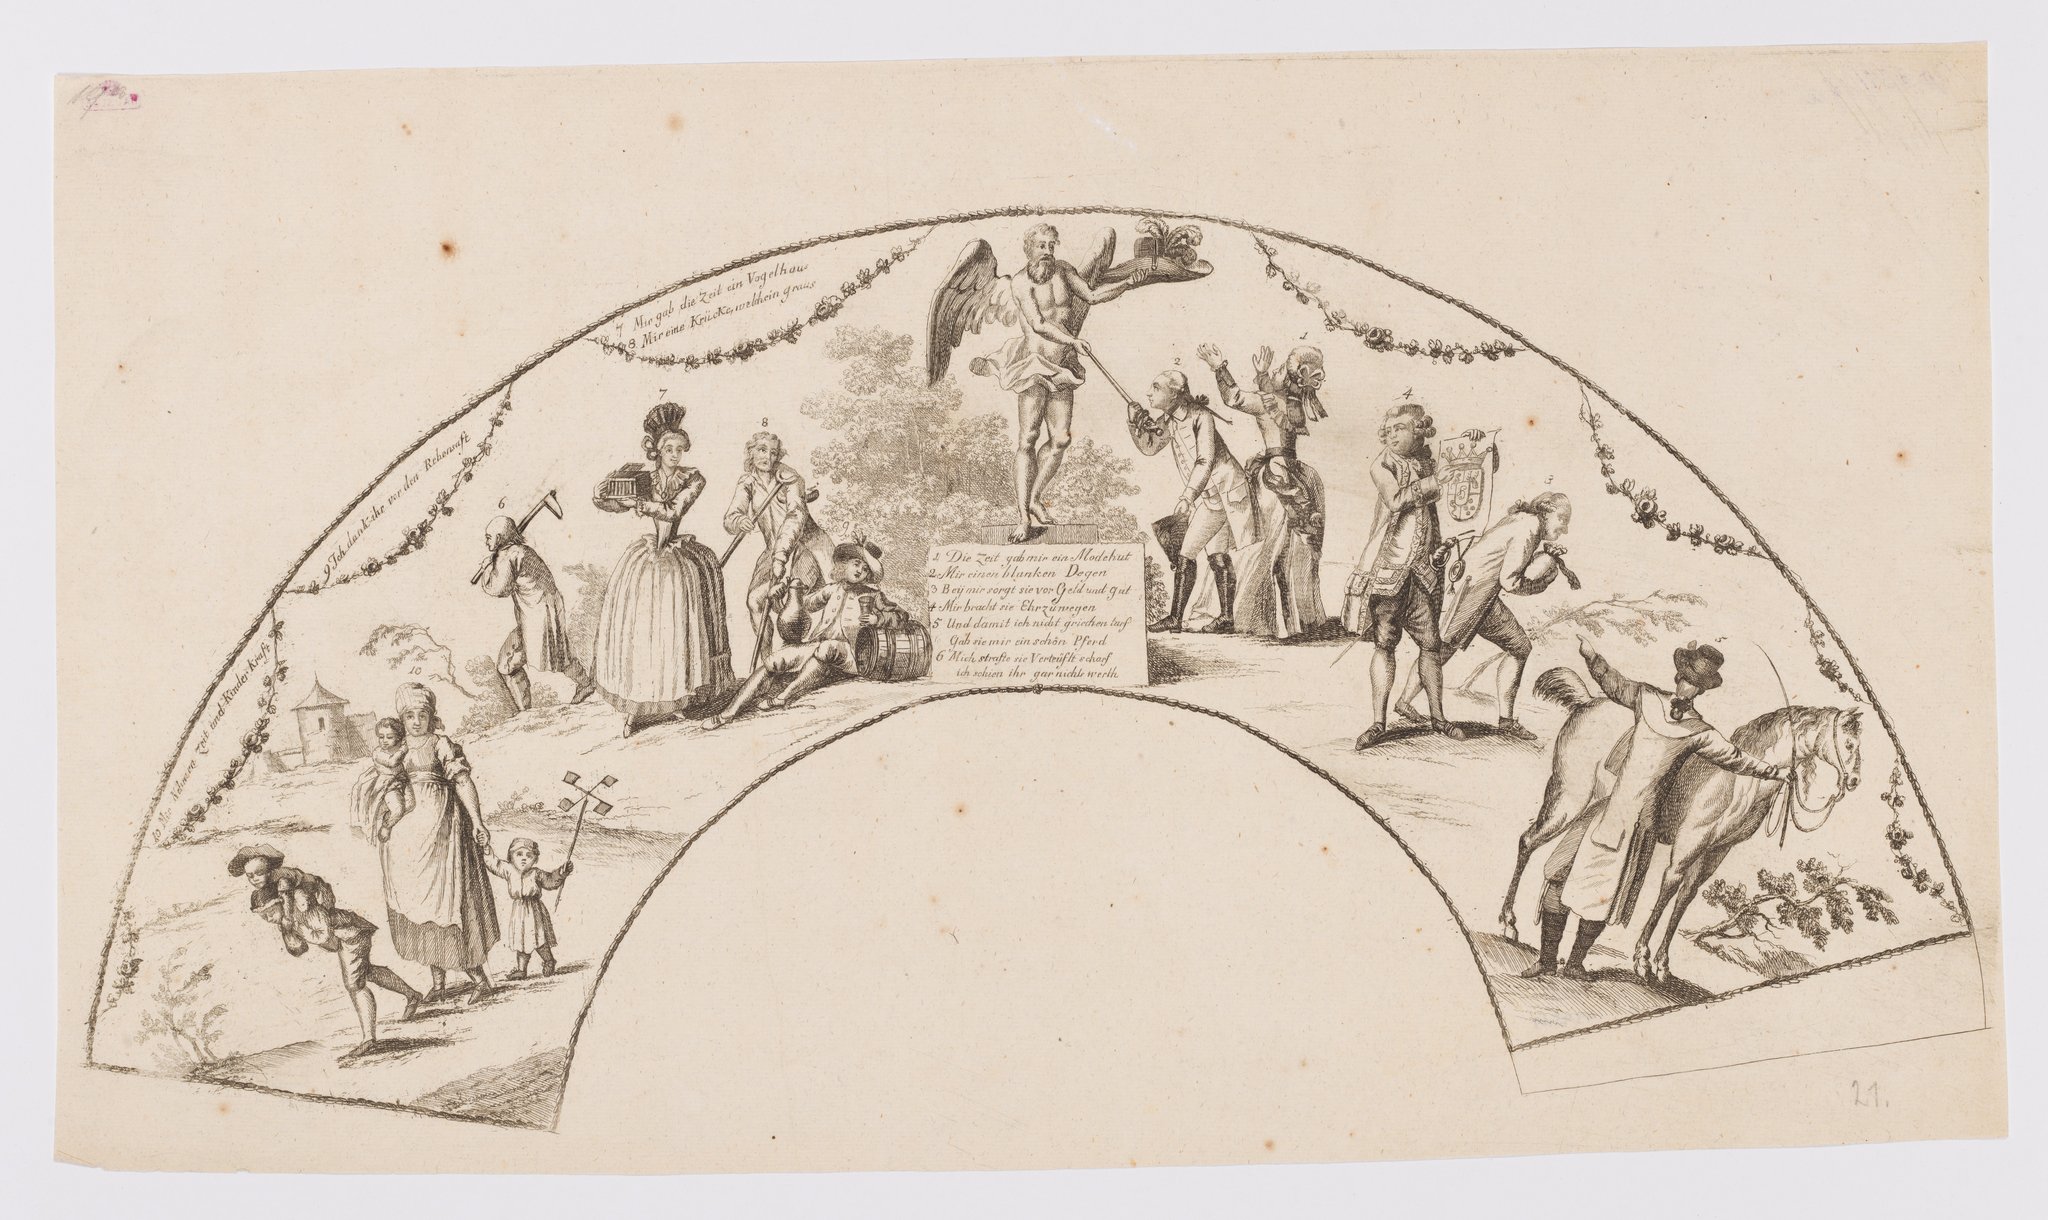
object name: print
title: Design for a fan depicting allegory of passage of time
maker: anonymous, austrian, 18th century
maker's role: artist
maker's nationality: austrian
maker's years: 1700-1800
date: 1701-1800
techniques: etching